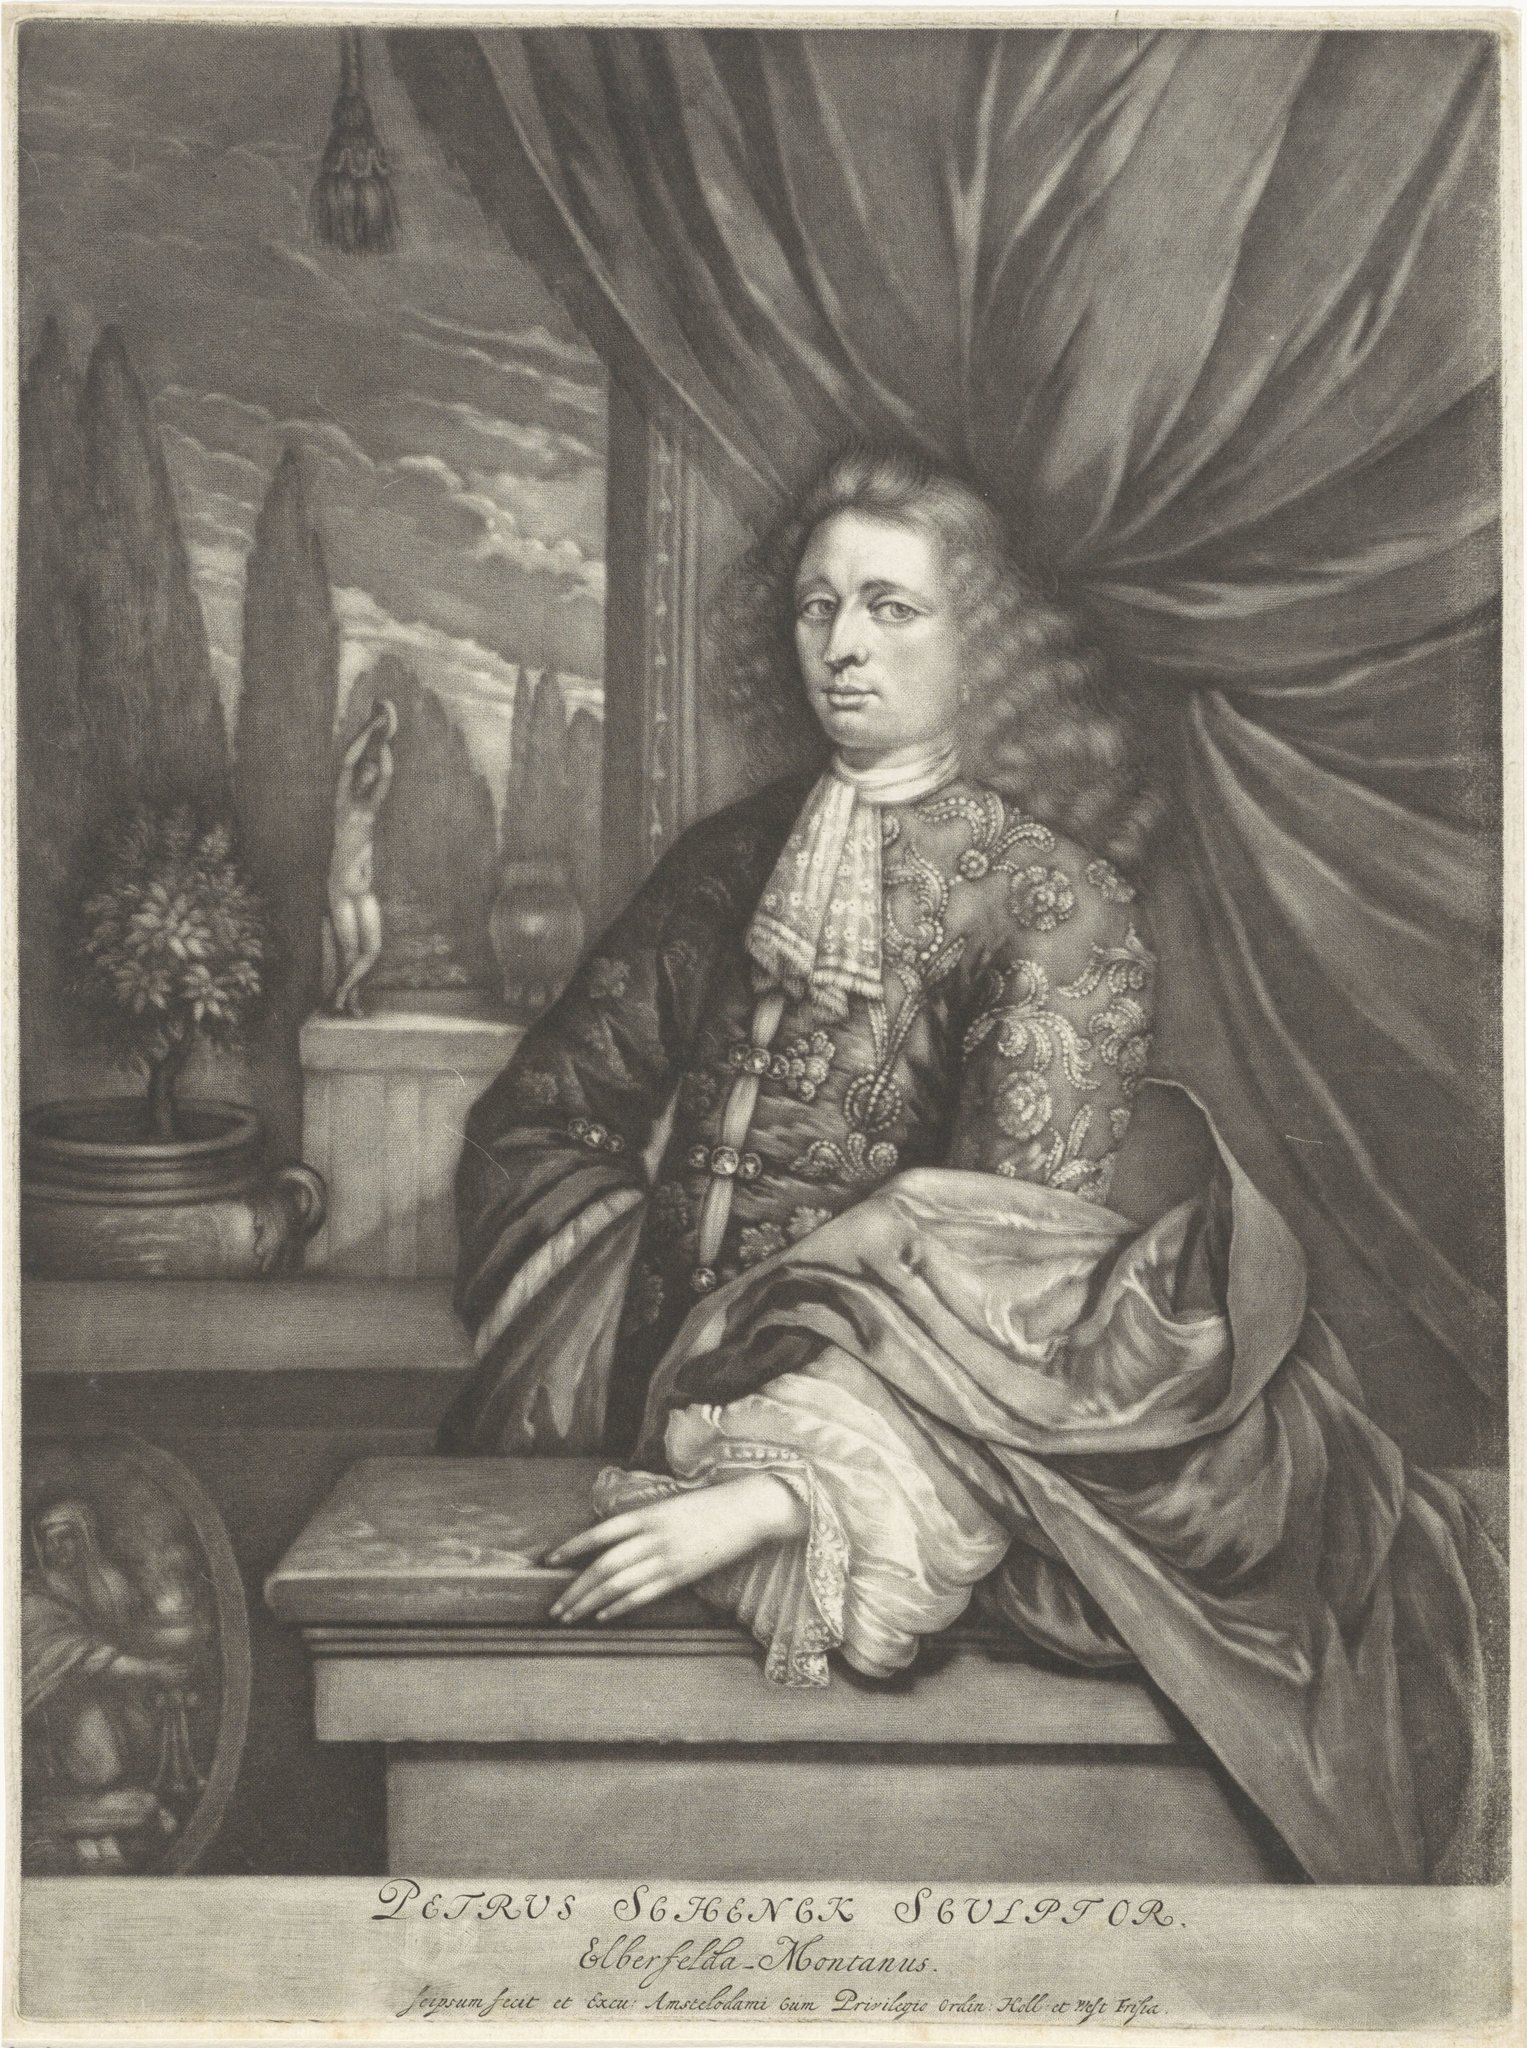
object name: print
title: Zelfportret van Pieter Schenk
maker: pieter schenk (i)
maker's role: print maker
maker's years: 1660-1711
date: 1680-1713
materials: paper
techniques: engraving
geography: amsterdam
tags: print maker, pieter schenk (i), garden, portrait, self-portrait of painter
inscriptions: collector's mark: Lugt 2228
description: De prentmaker en uitgever Pieter Schenk staat onder een draperie. Op de achtergrond een tuin met een sculptuur van een naakte vrouw.